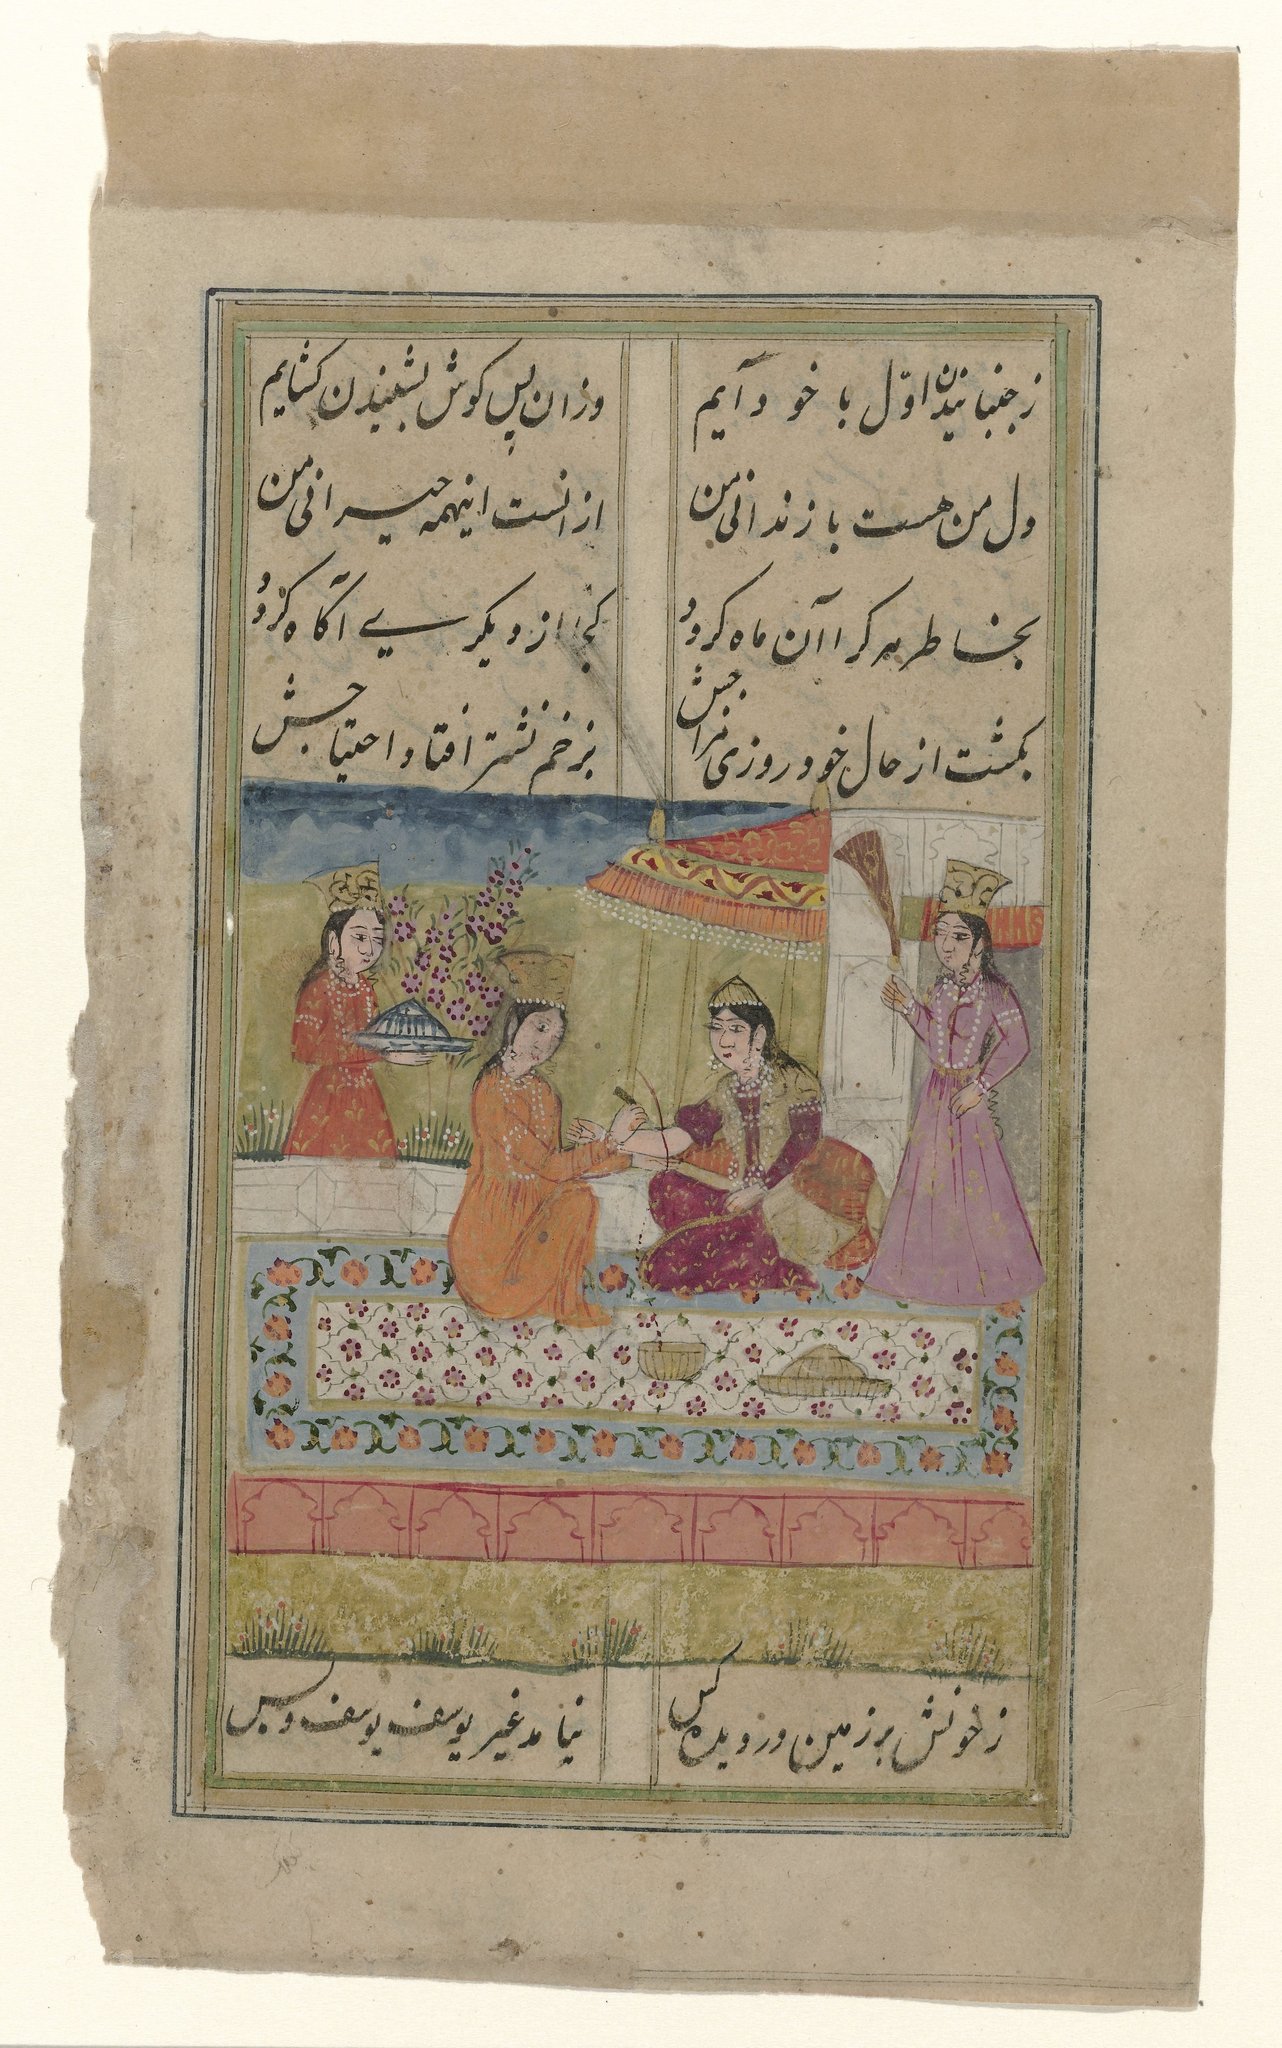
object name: indian miniature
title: Twee dames met hun bedienden op een terras voor een paleis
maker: Anonymous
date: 1790-1810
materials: paper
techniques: brush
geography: kashmir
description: Op een terras onder een baldakijn zitten twee vrouwen; achter elk van hen een bediende met een schaal en een met een waaier. De voorstelling ligt net onder het midden van het blad over twee kolommen tekst, die op de achterkant doorgaat.